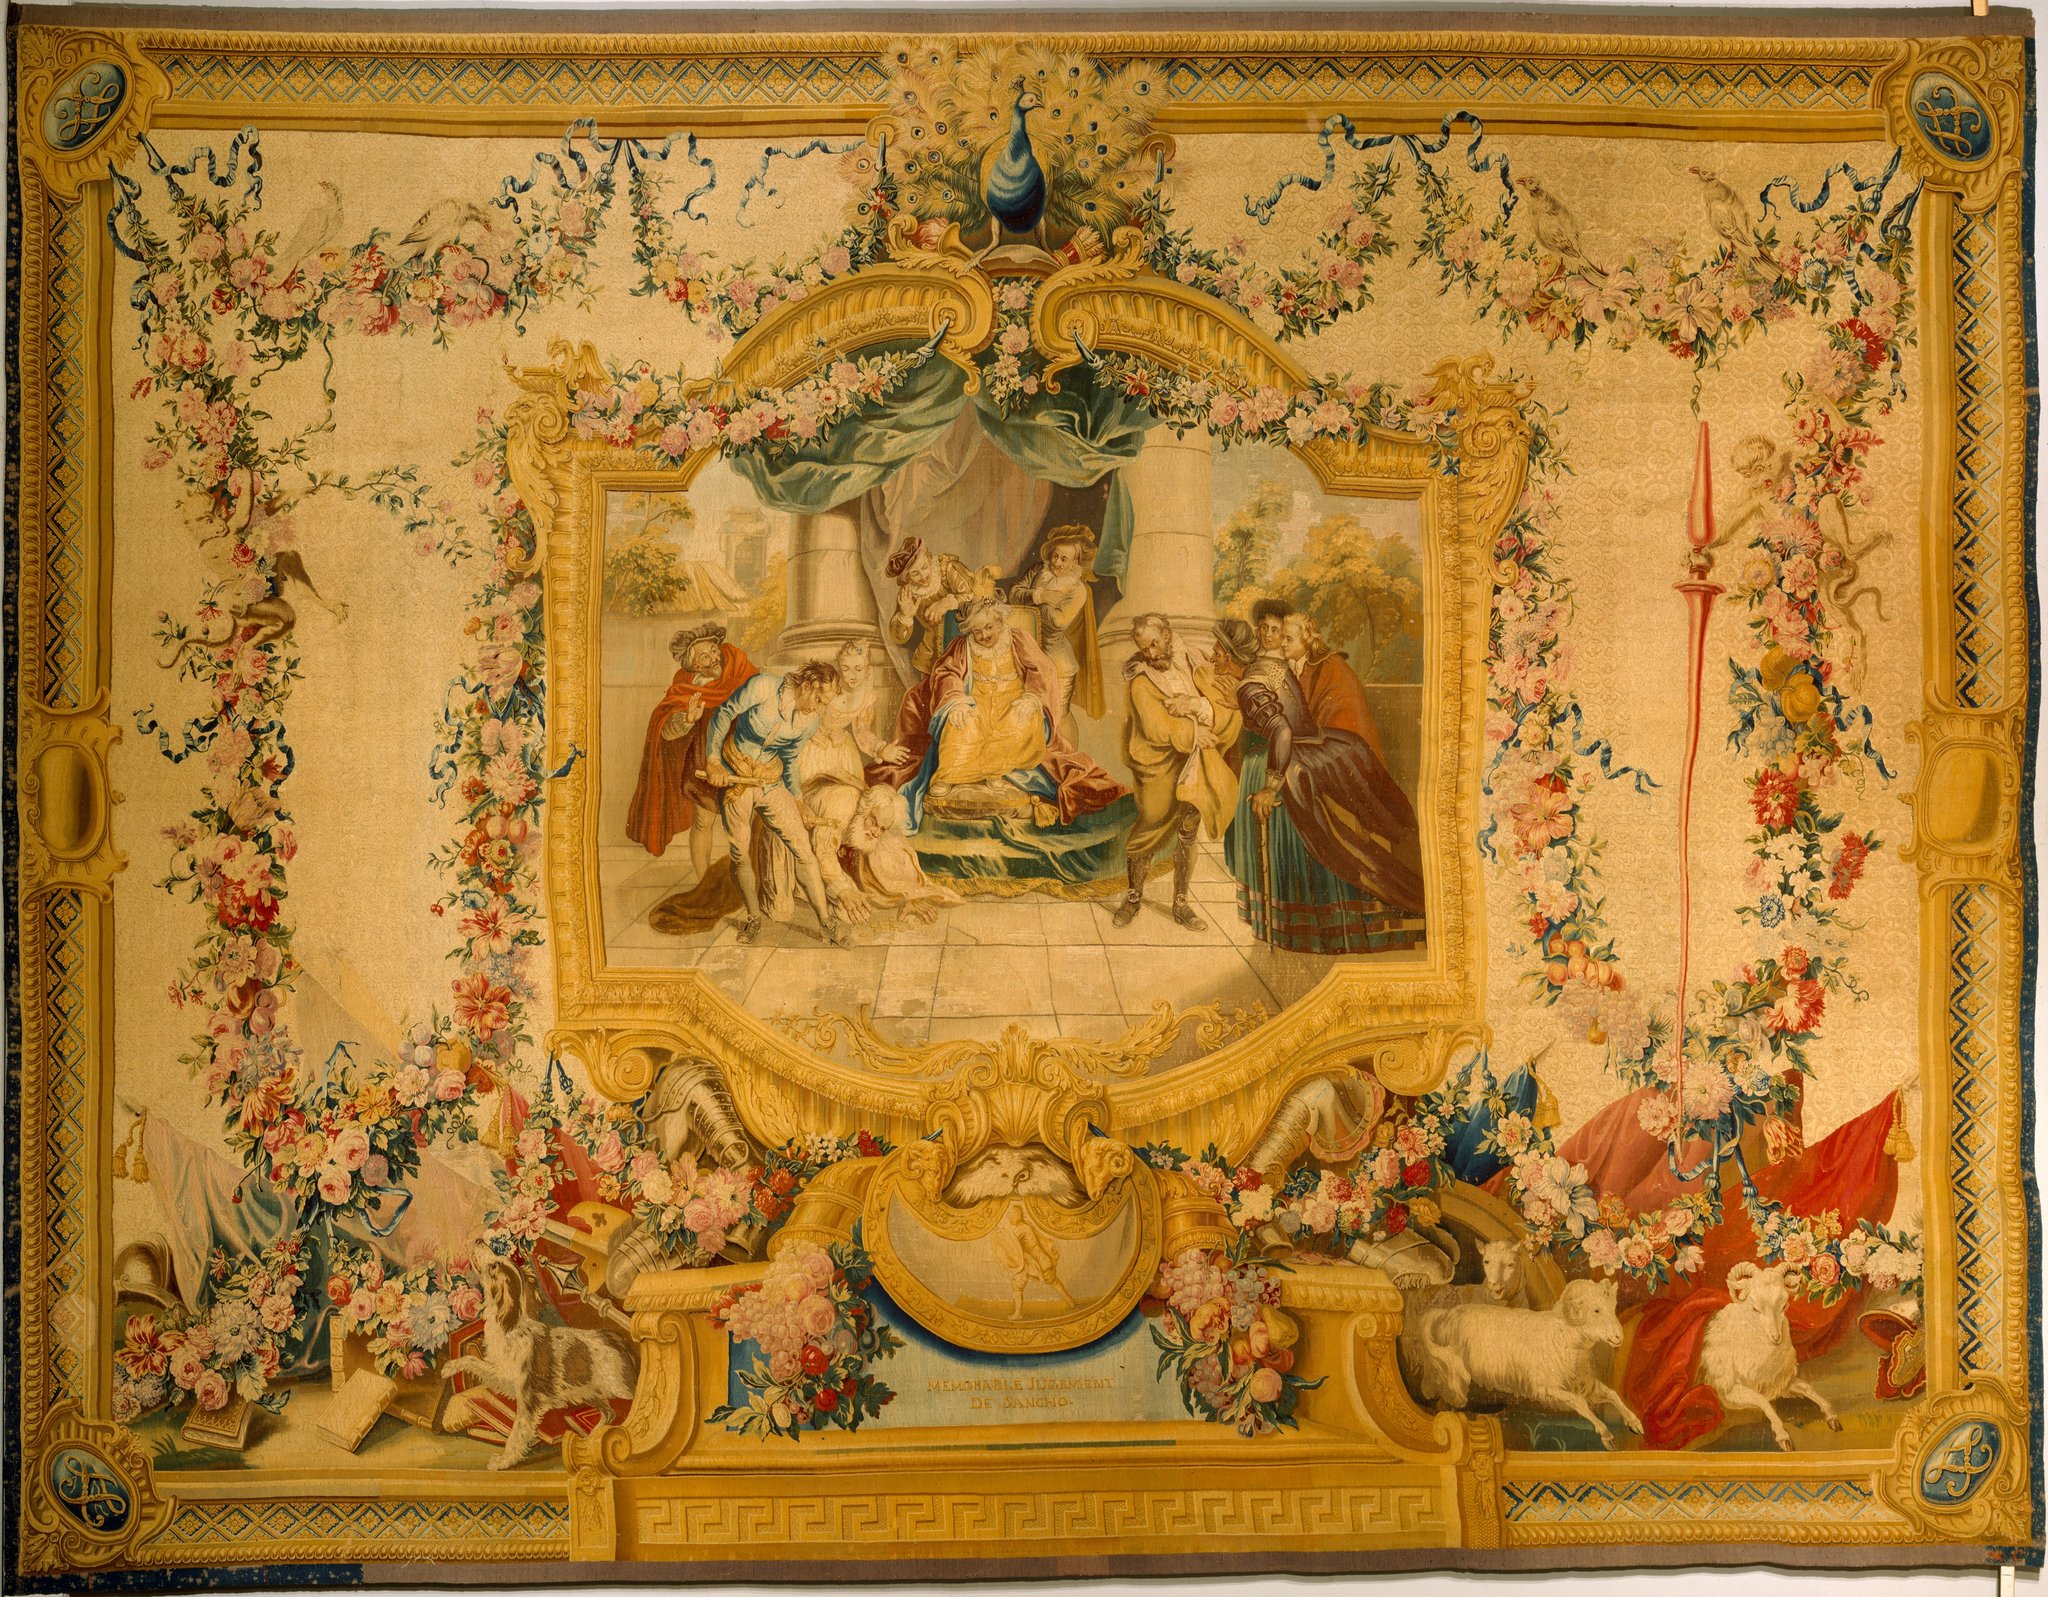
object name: tapestry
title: The Memorable Judgment of Sancho Panza from a series of tapestries with scenes from Don Quixote (number twenty-four in a series of twenty-eight)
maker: manufacture nationale des gobelins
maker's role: manufactory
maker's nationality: french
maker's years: 1662-1799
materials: silk, wool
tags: garlands,men,women,peacocks,dogs,rams,don quixote